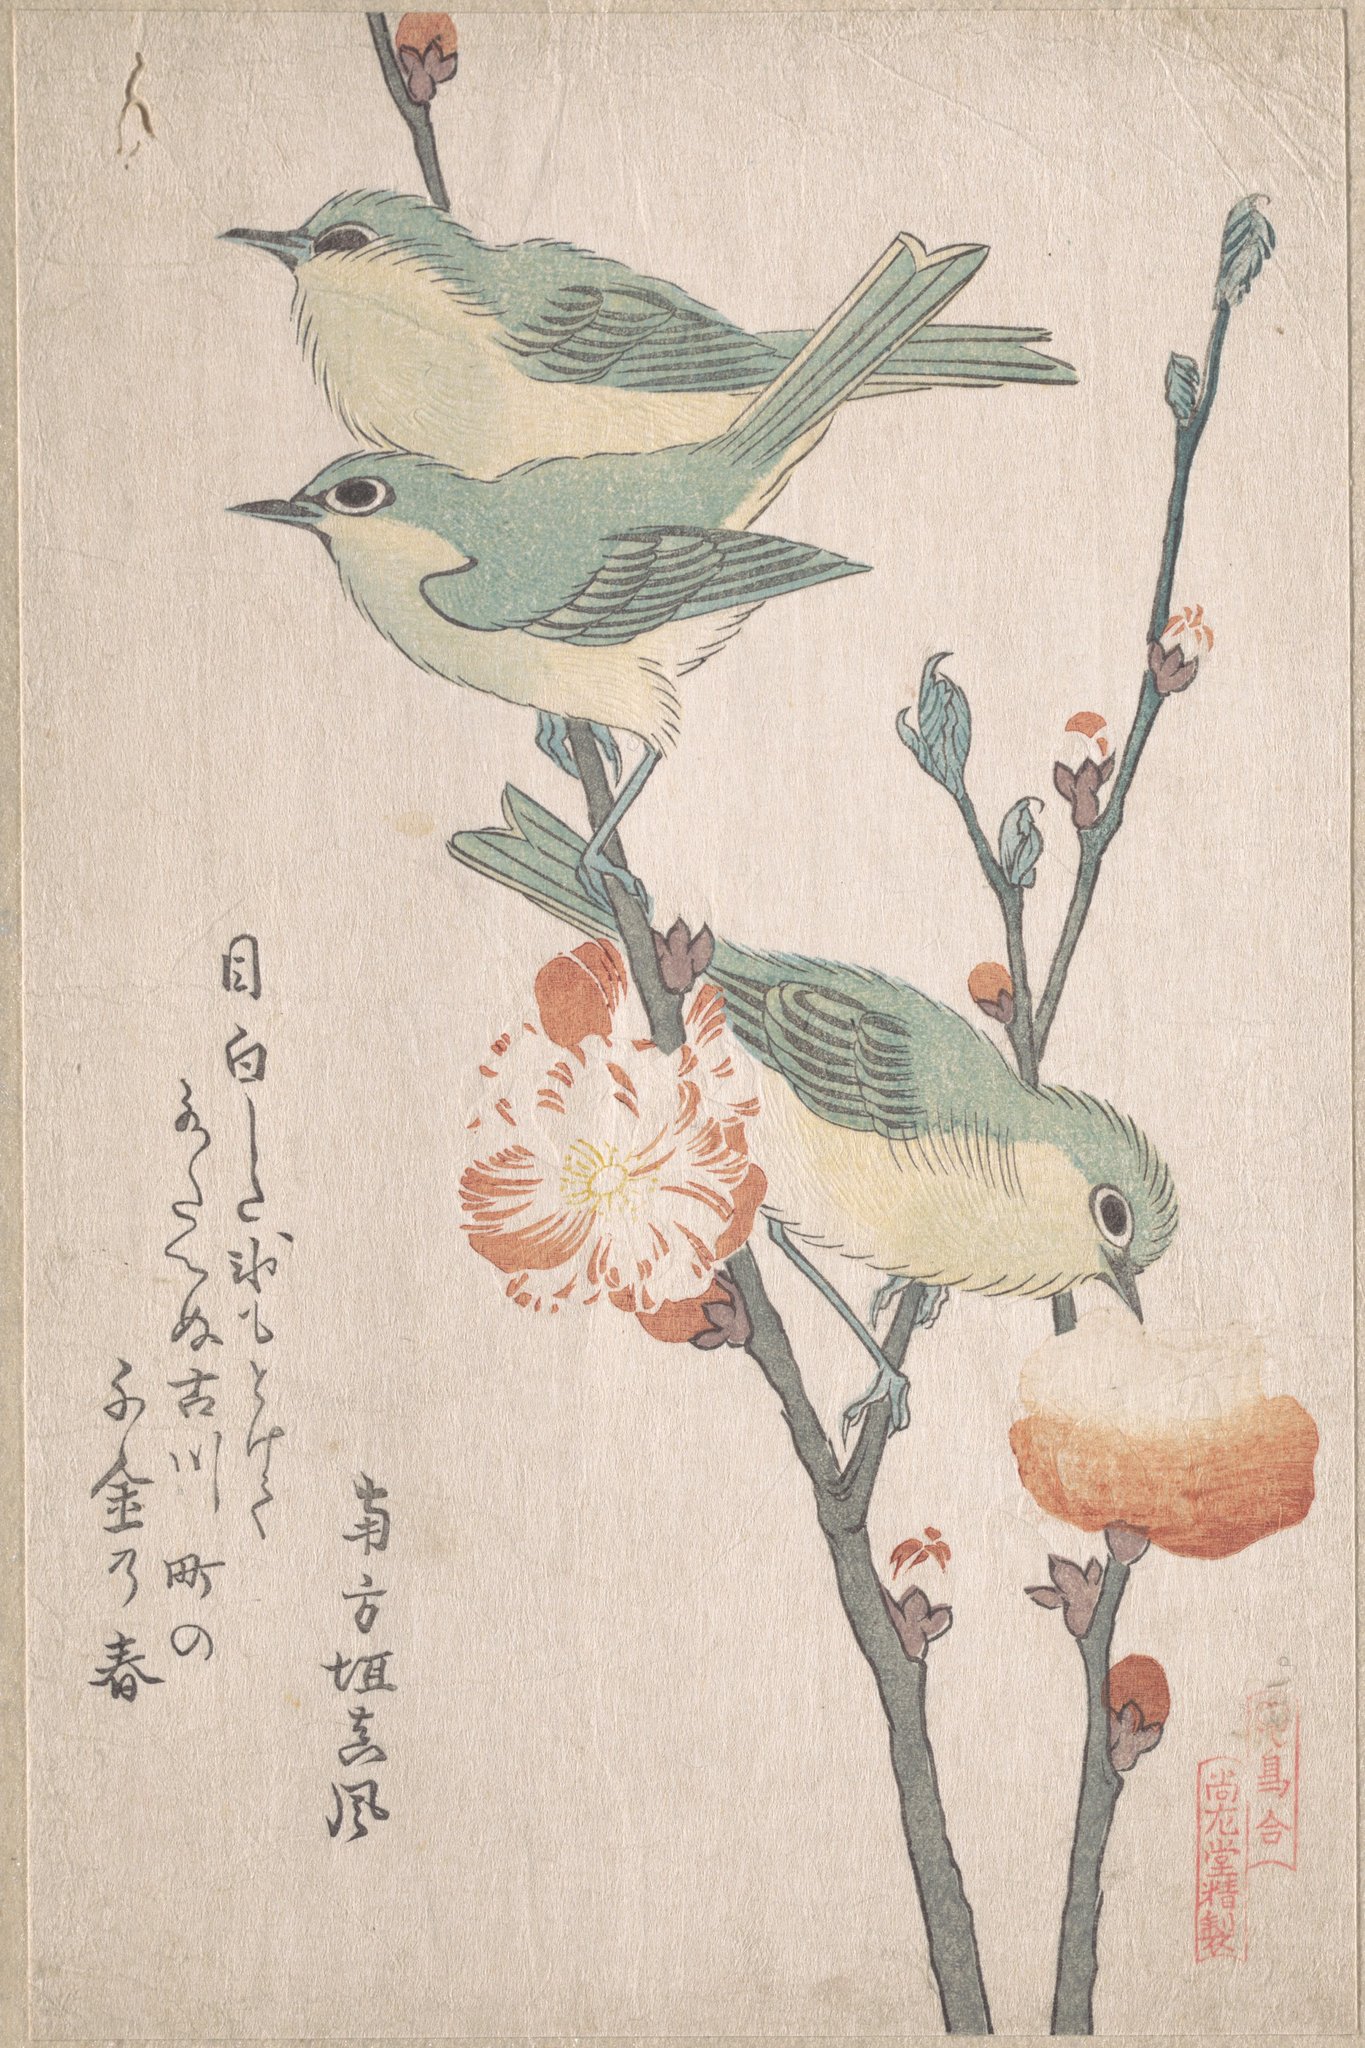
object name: woodblock print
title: Japanese White-eyes on a Branch of Peach Tree,” from the Series An Array of Birds (Tori awase), from Spring Rain Surimono Album (Harusame surimono-jō, vol. 3)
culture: japanese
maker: kubo shunman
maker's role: artist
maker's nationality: japanese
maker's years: 1757-1820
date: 1805-1810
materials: ink, paper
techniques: surimono, woodblock print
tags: birds,flowers,trees